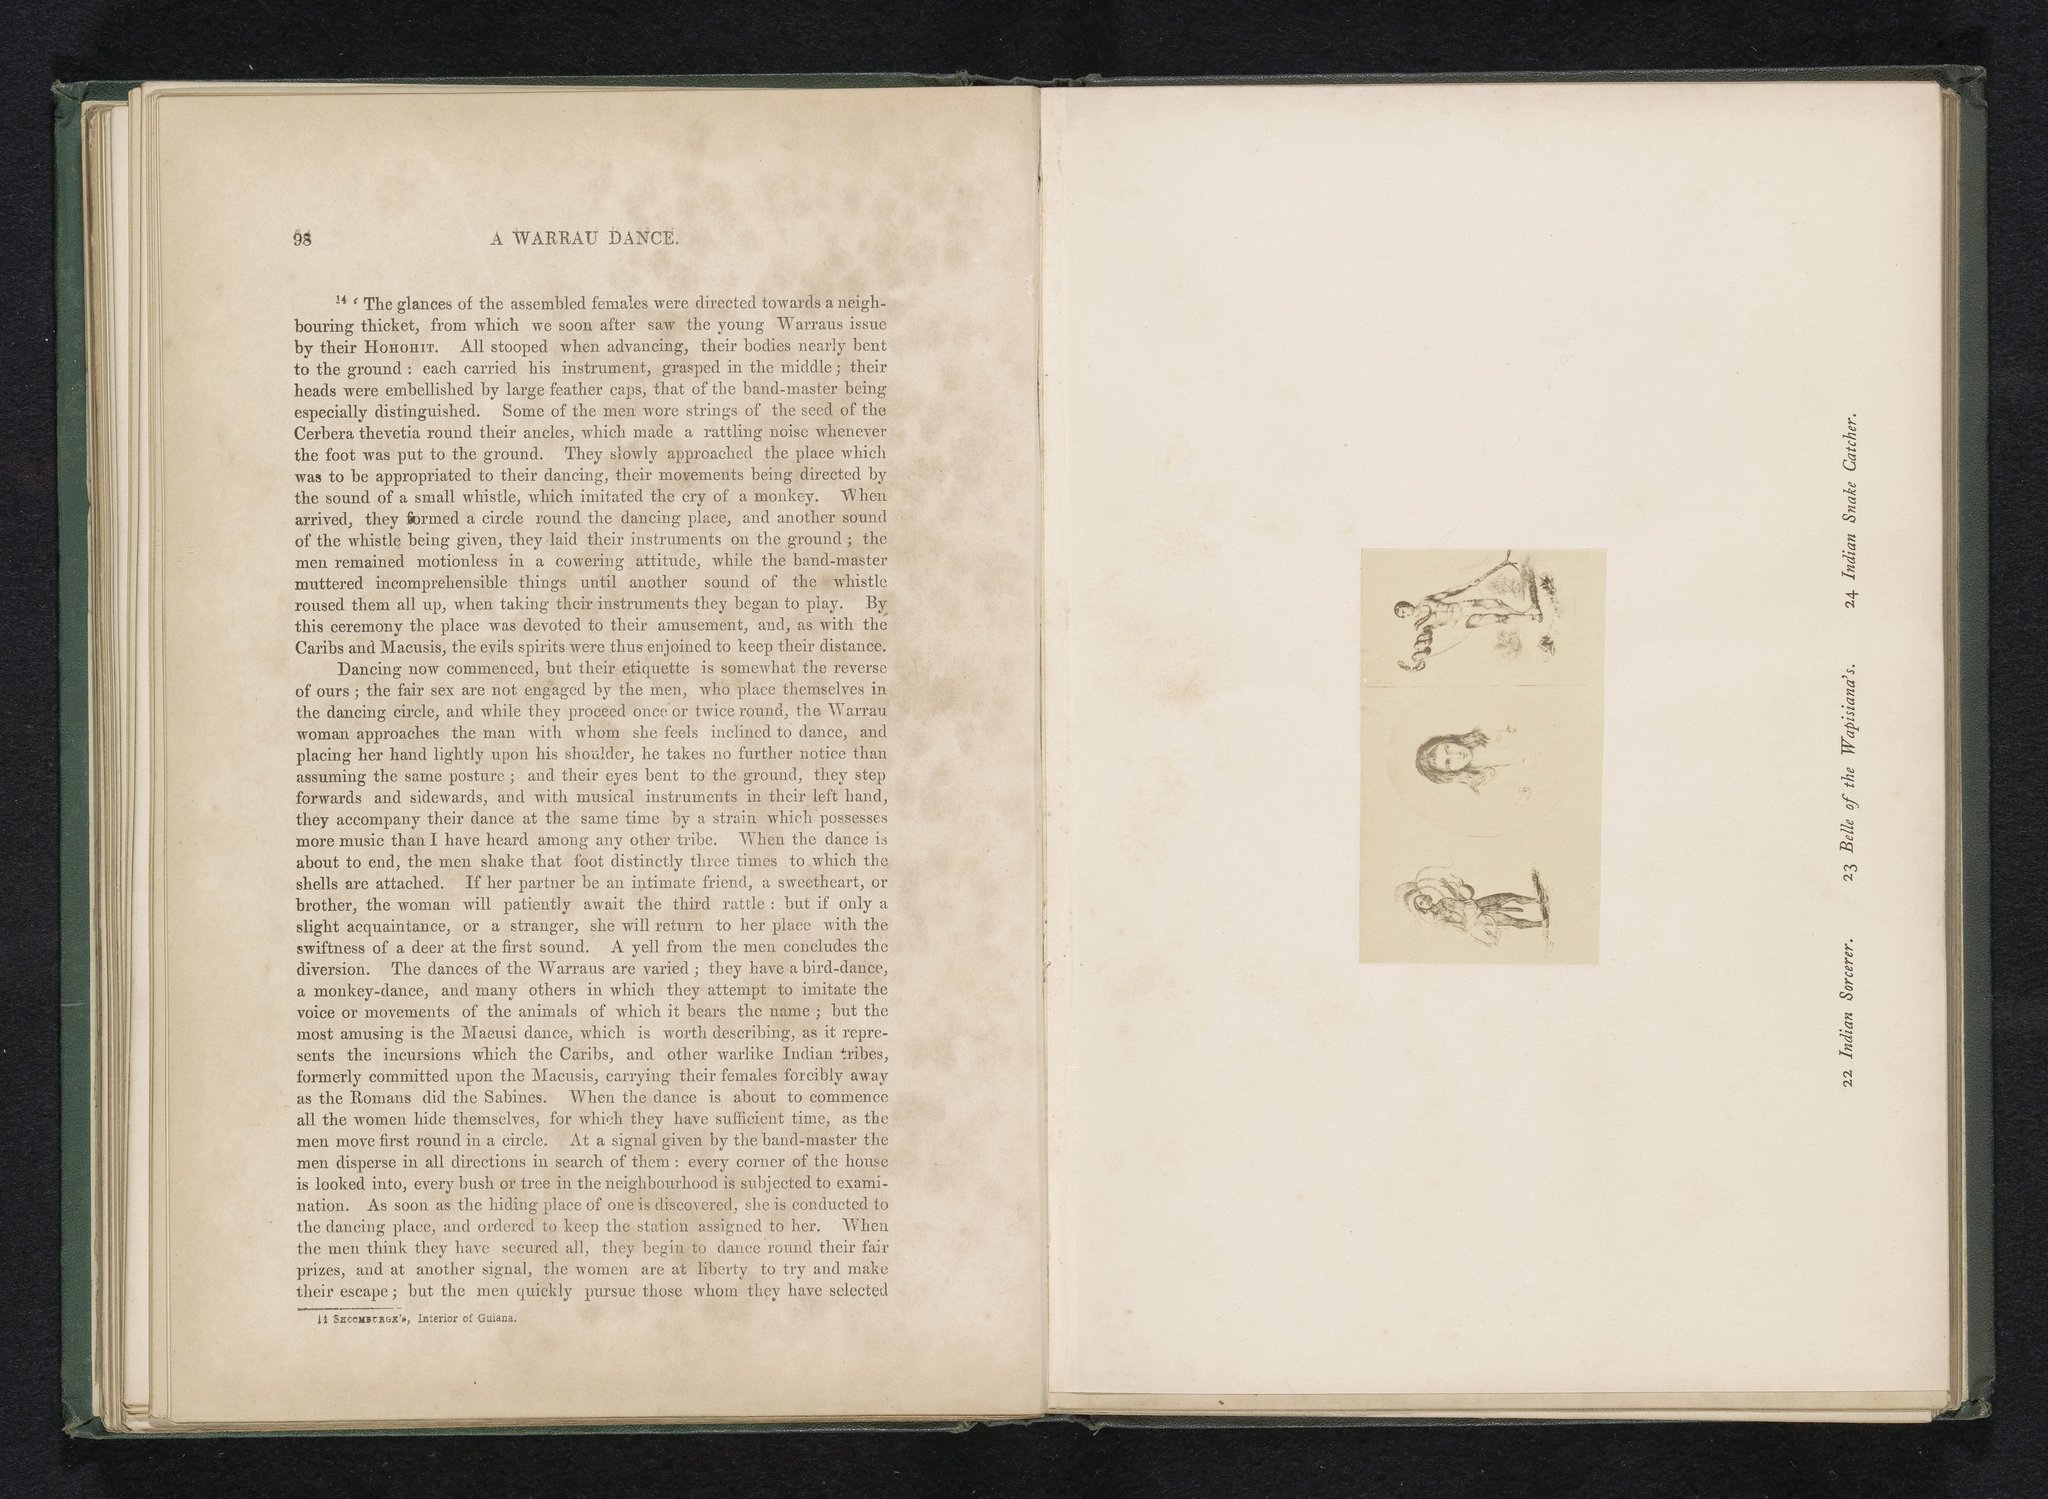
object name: reproduction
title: Fotoreproductie van een tekening van drie mensen van de inheemse bevolking van Guyana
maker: Anonymous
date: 1856-1866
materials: photographic support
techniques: albumen print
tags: human types; peoples and nationalities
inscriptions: number: ‘22 23 24’